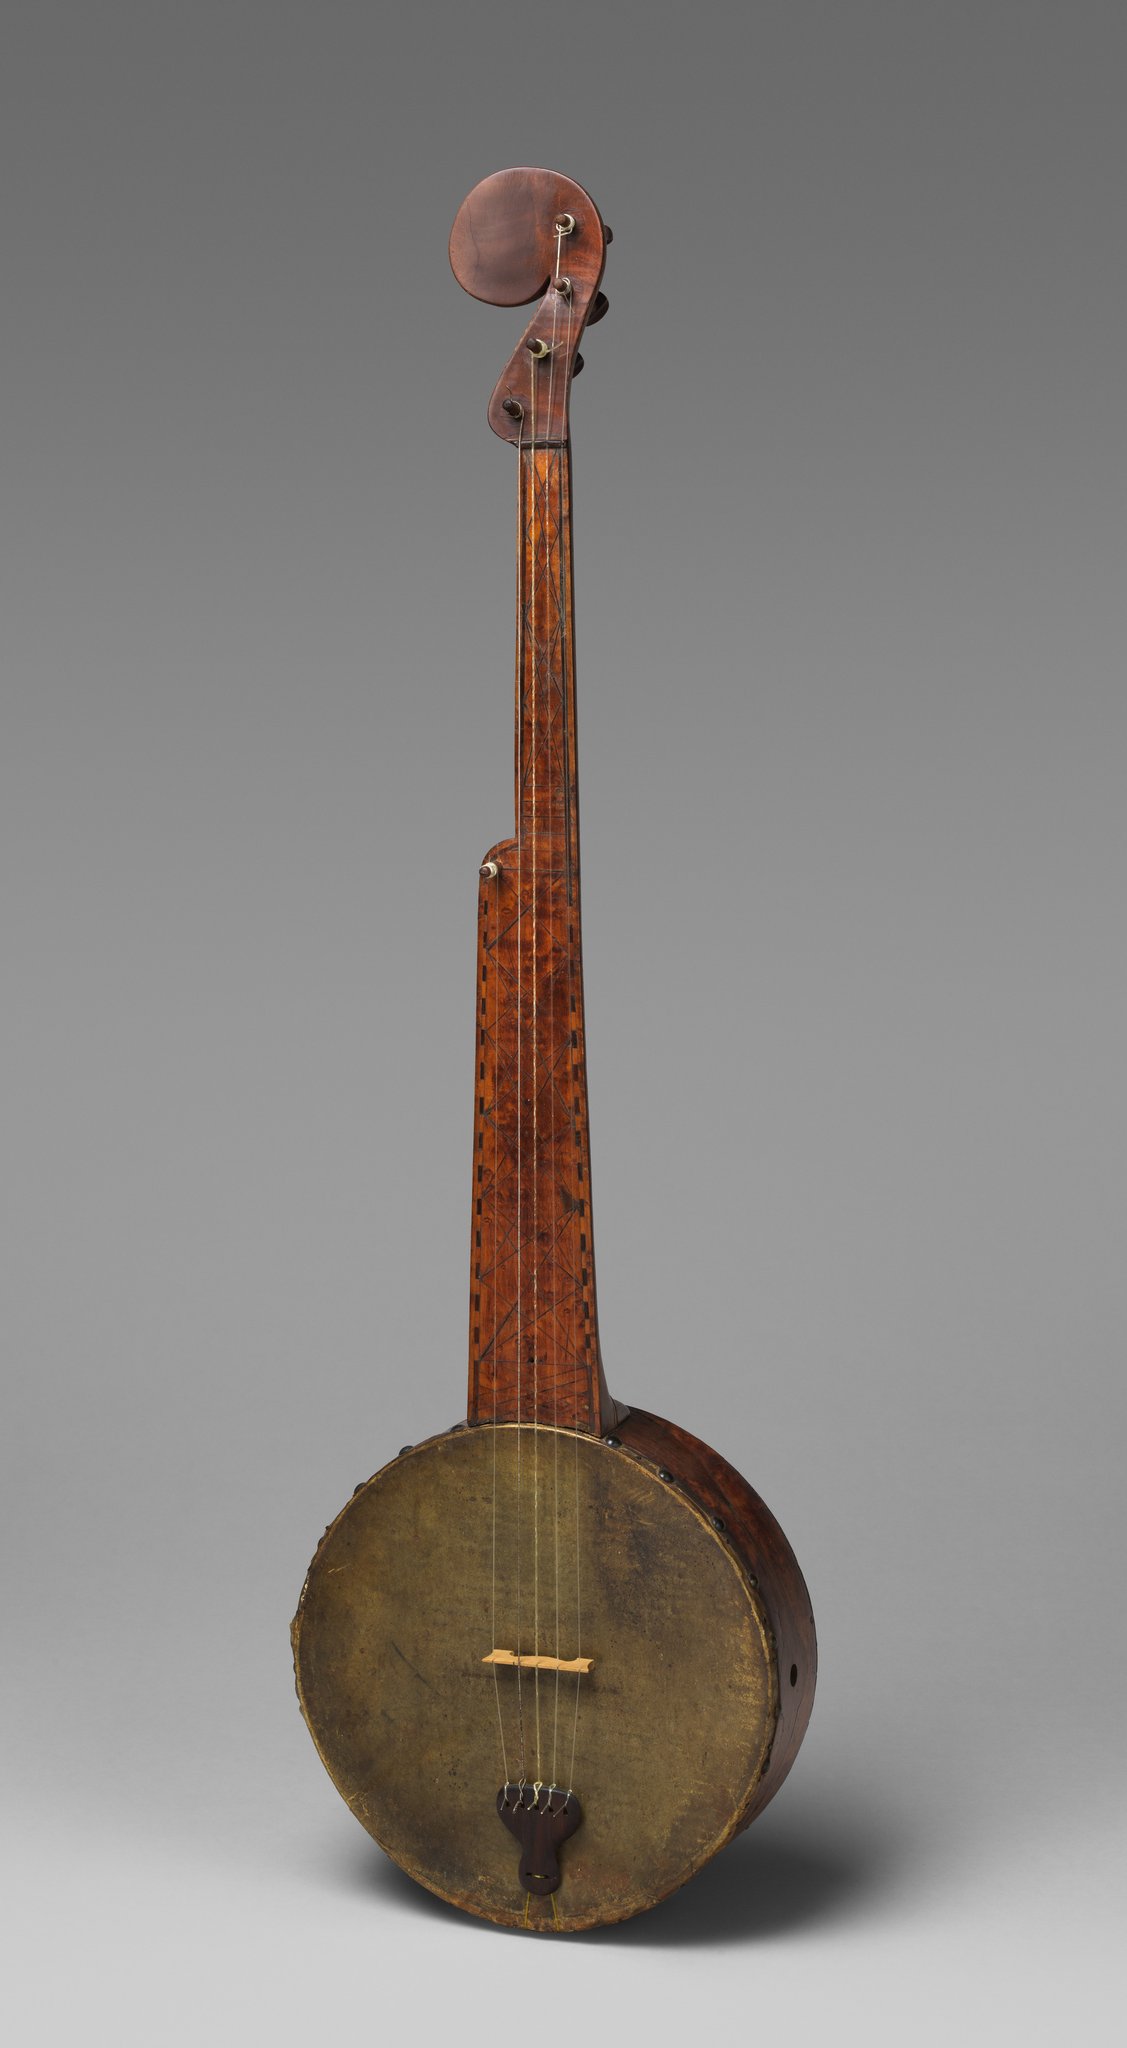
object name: fretless tackhead banjo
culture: american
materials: wood, metal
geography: united states